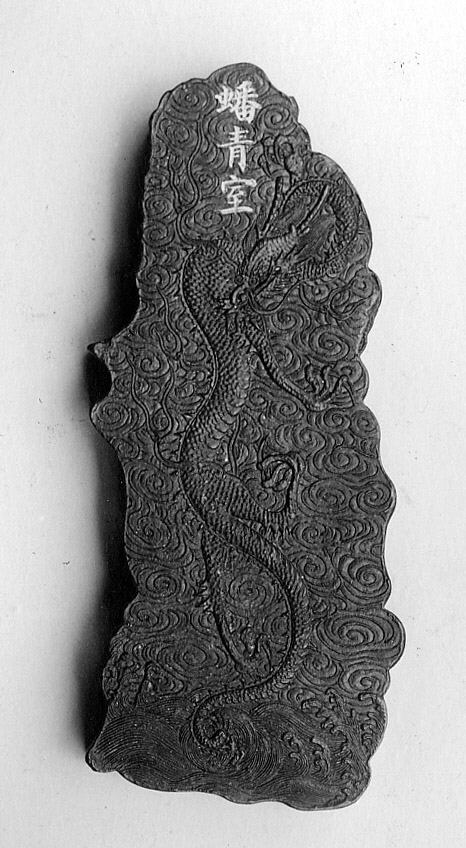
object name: ink tablet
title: The Creeping Green Room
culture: chinese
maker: jian guzhai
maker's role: artist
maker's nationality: chinese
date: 1867-1933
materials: ink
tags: dragons